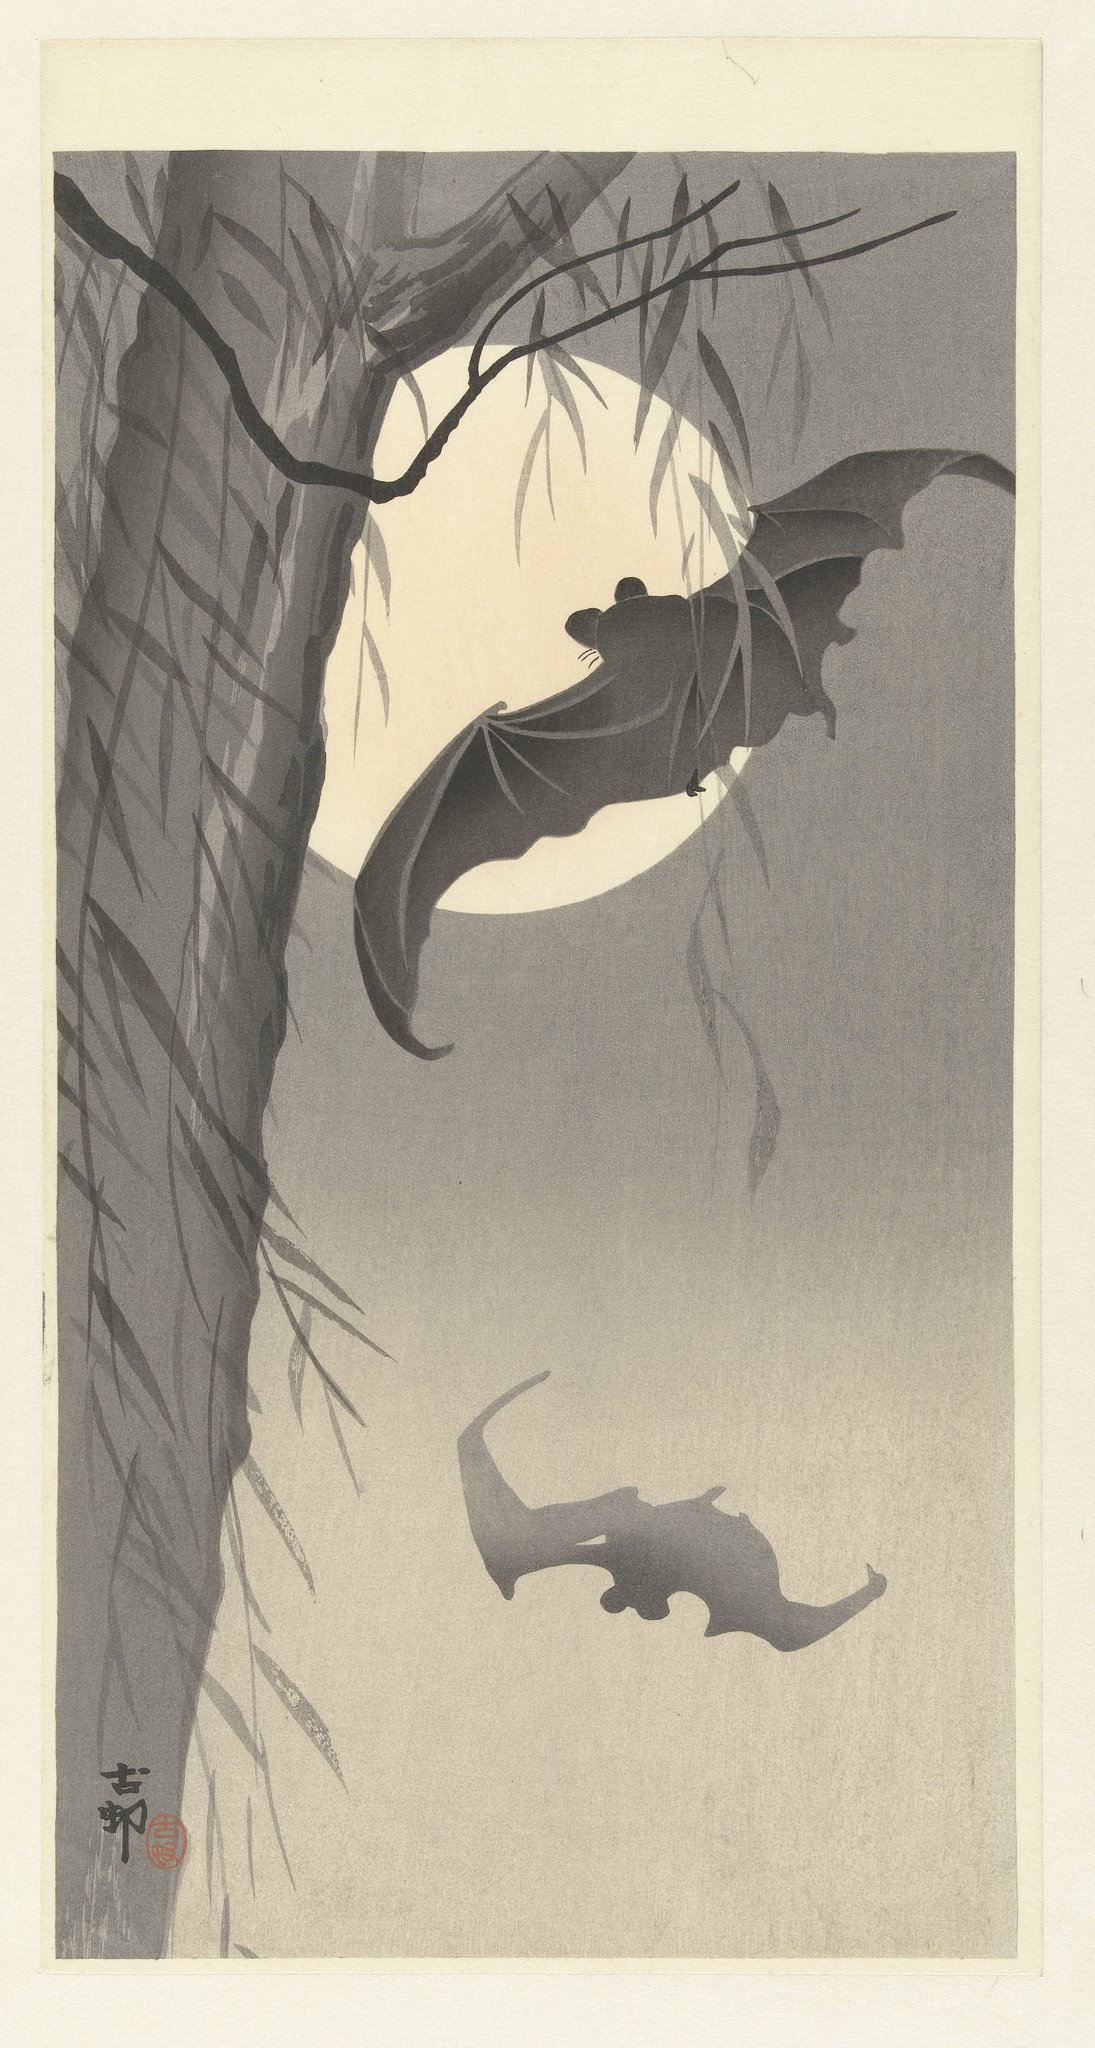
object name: print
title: Twee vleermuizen bij volle maan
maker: ohara koson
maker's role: print maker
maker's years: 1877-1945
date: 1900-1936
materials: paper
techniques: woodcut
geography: japan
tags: full moon, trees, flying mammals: bat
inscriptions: collector's mark: Lugt 2228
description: Twee vliegende vleermuizen bij volle maan; links een wilg.